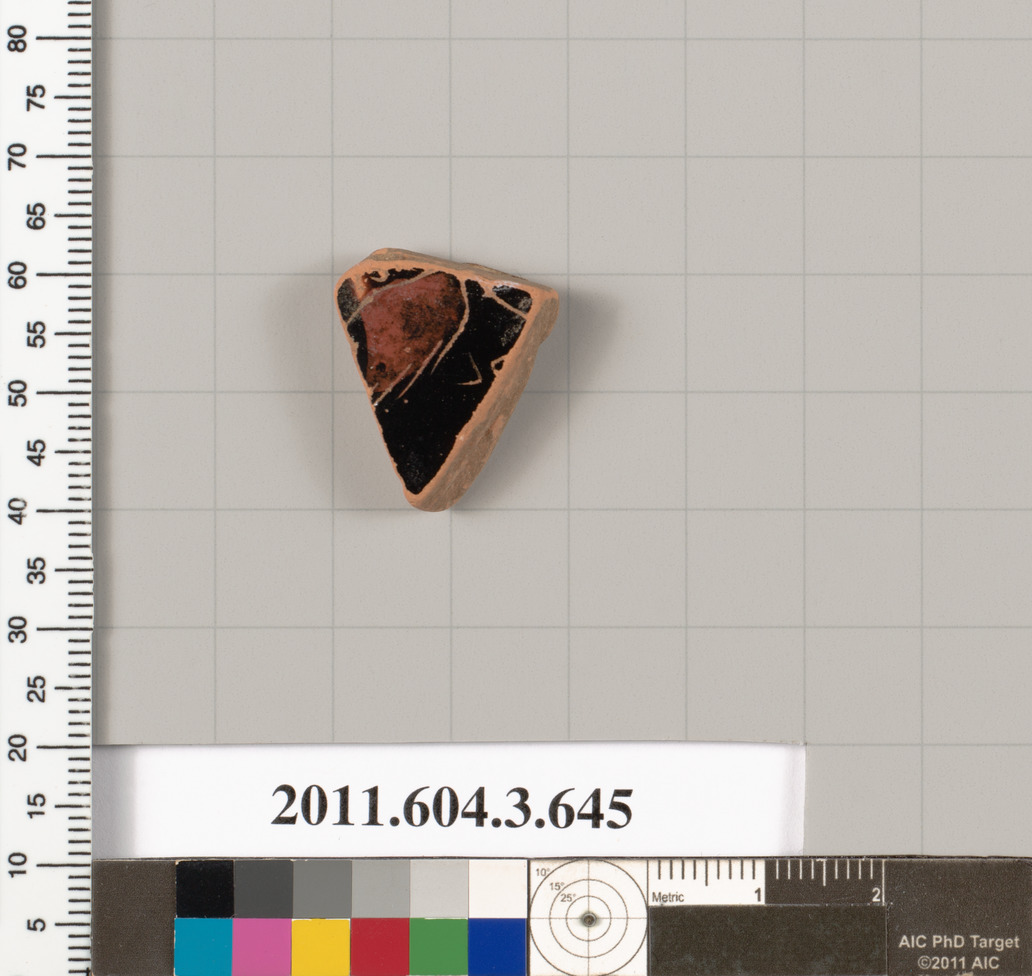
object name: column krater fragment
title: Terracotta fragment of a column-krater (bowl for mixing wine and water)?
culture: greek, attic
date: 534-468 BCE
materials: terracotta